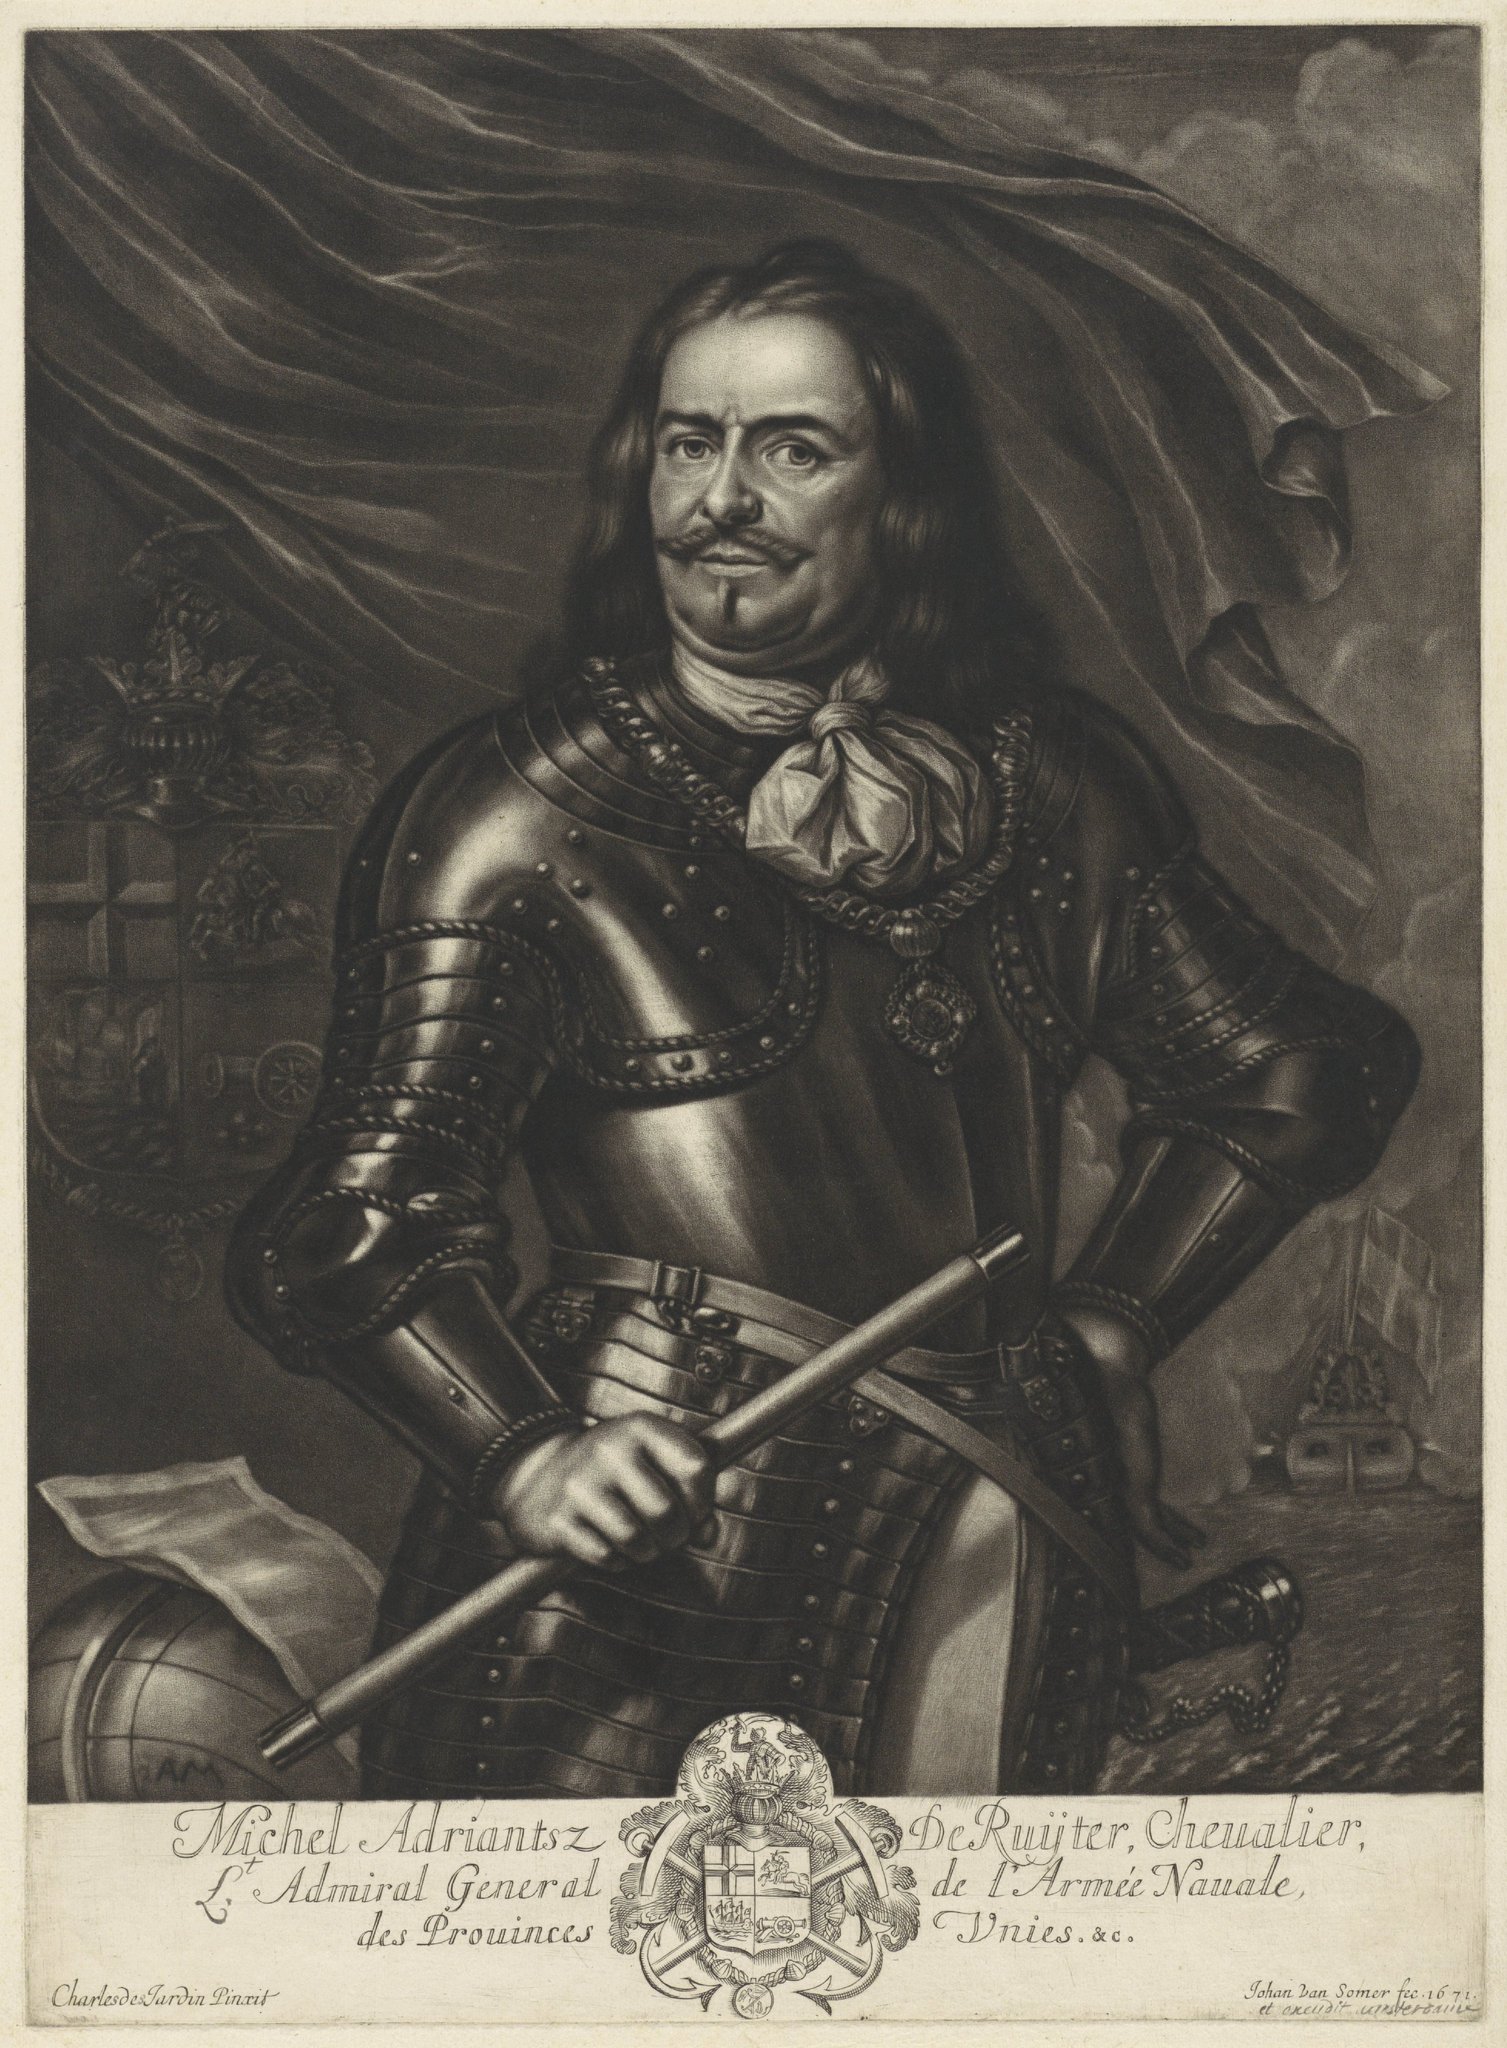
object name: print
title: Portret van Michiel Adriaenszoon de Ruyter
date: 1671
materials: paper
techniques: engraving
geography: amsterdam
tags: flushing, michiel adriaenszoon de ruyter, sailing-ship, sailing-boat, historical persons, armorial bearing, heraldry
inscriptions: collector's mark: Lugt 2228, inscription: ‘et excudit Amserdame’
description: Admiraal Michiel Adriaenszoon de Ruyter in een harnas met om zijn hals een keten waaraan een medaillon. Hij heeft de commandostaf in zijn hand. Op de achtergrond een schip, een vlag en zijn familiewapen. In de marge zijn naam, titels en familiewapen.